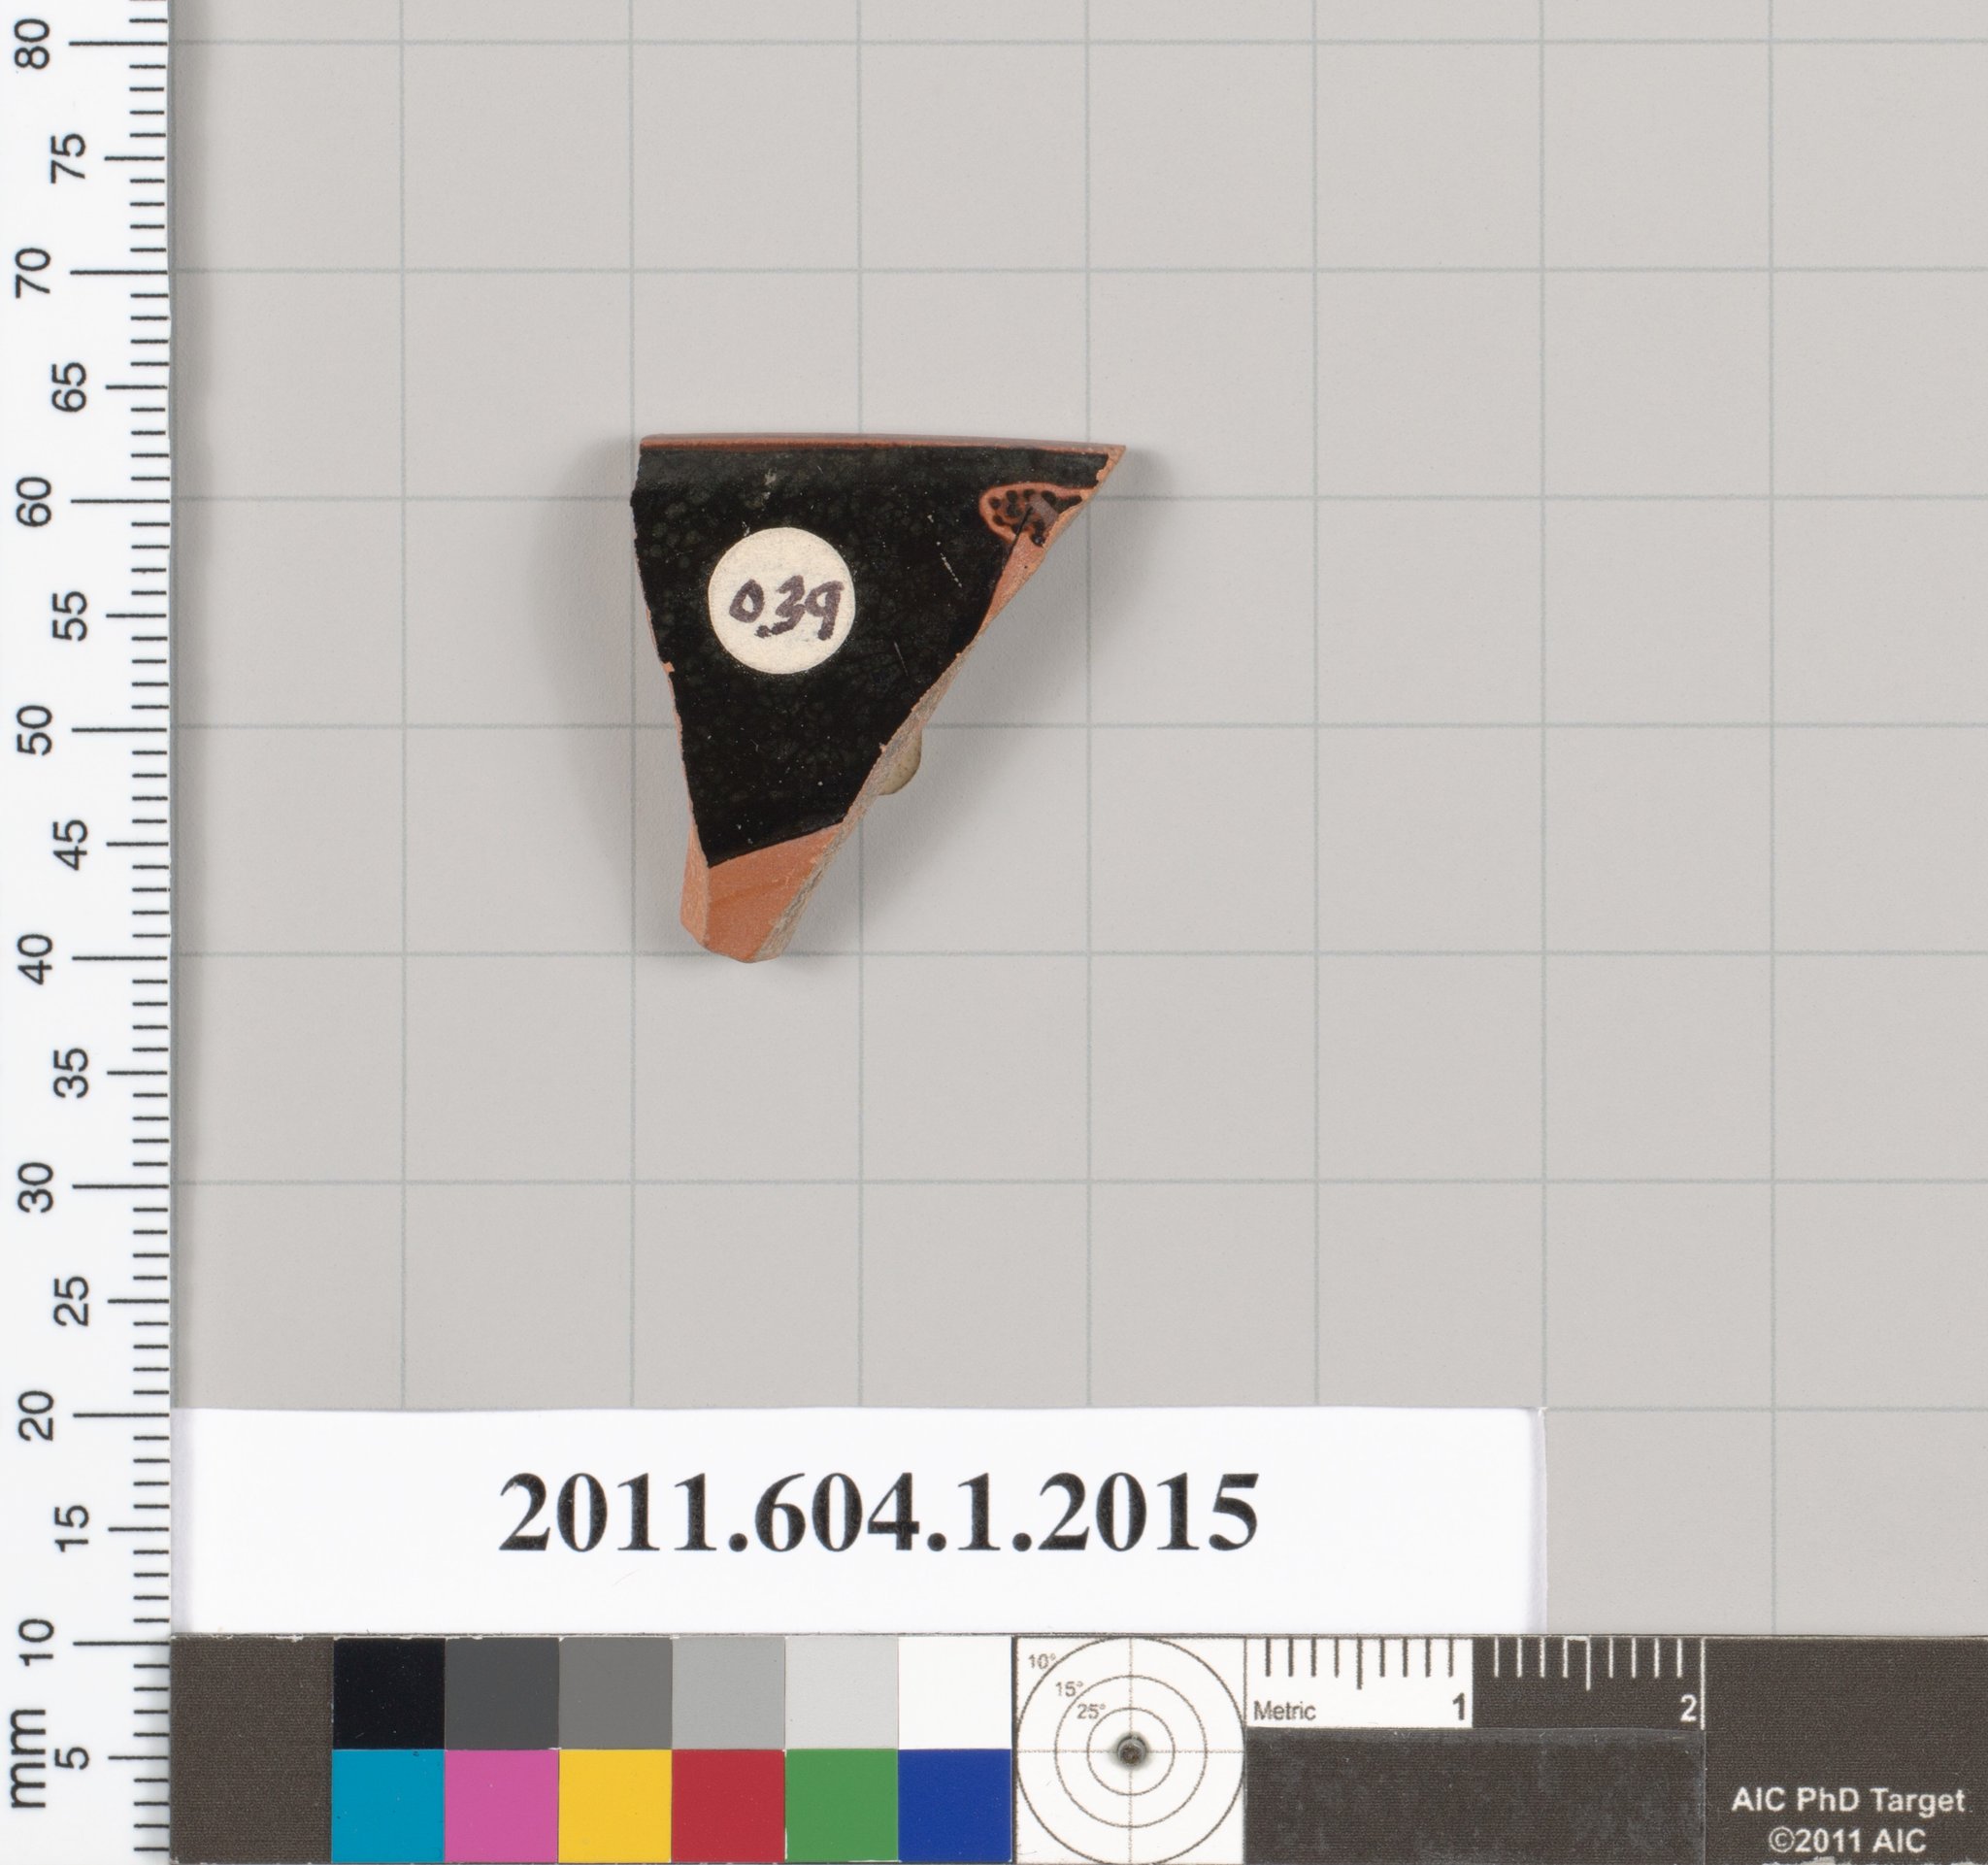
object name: kylix fragment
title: Terracotta rim fragment of a kylix (drinking cup)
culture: greek, attic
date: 500-401 BCE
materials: terracotta